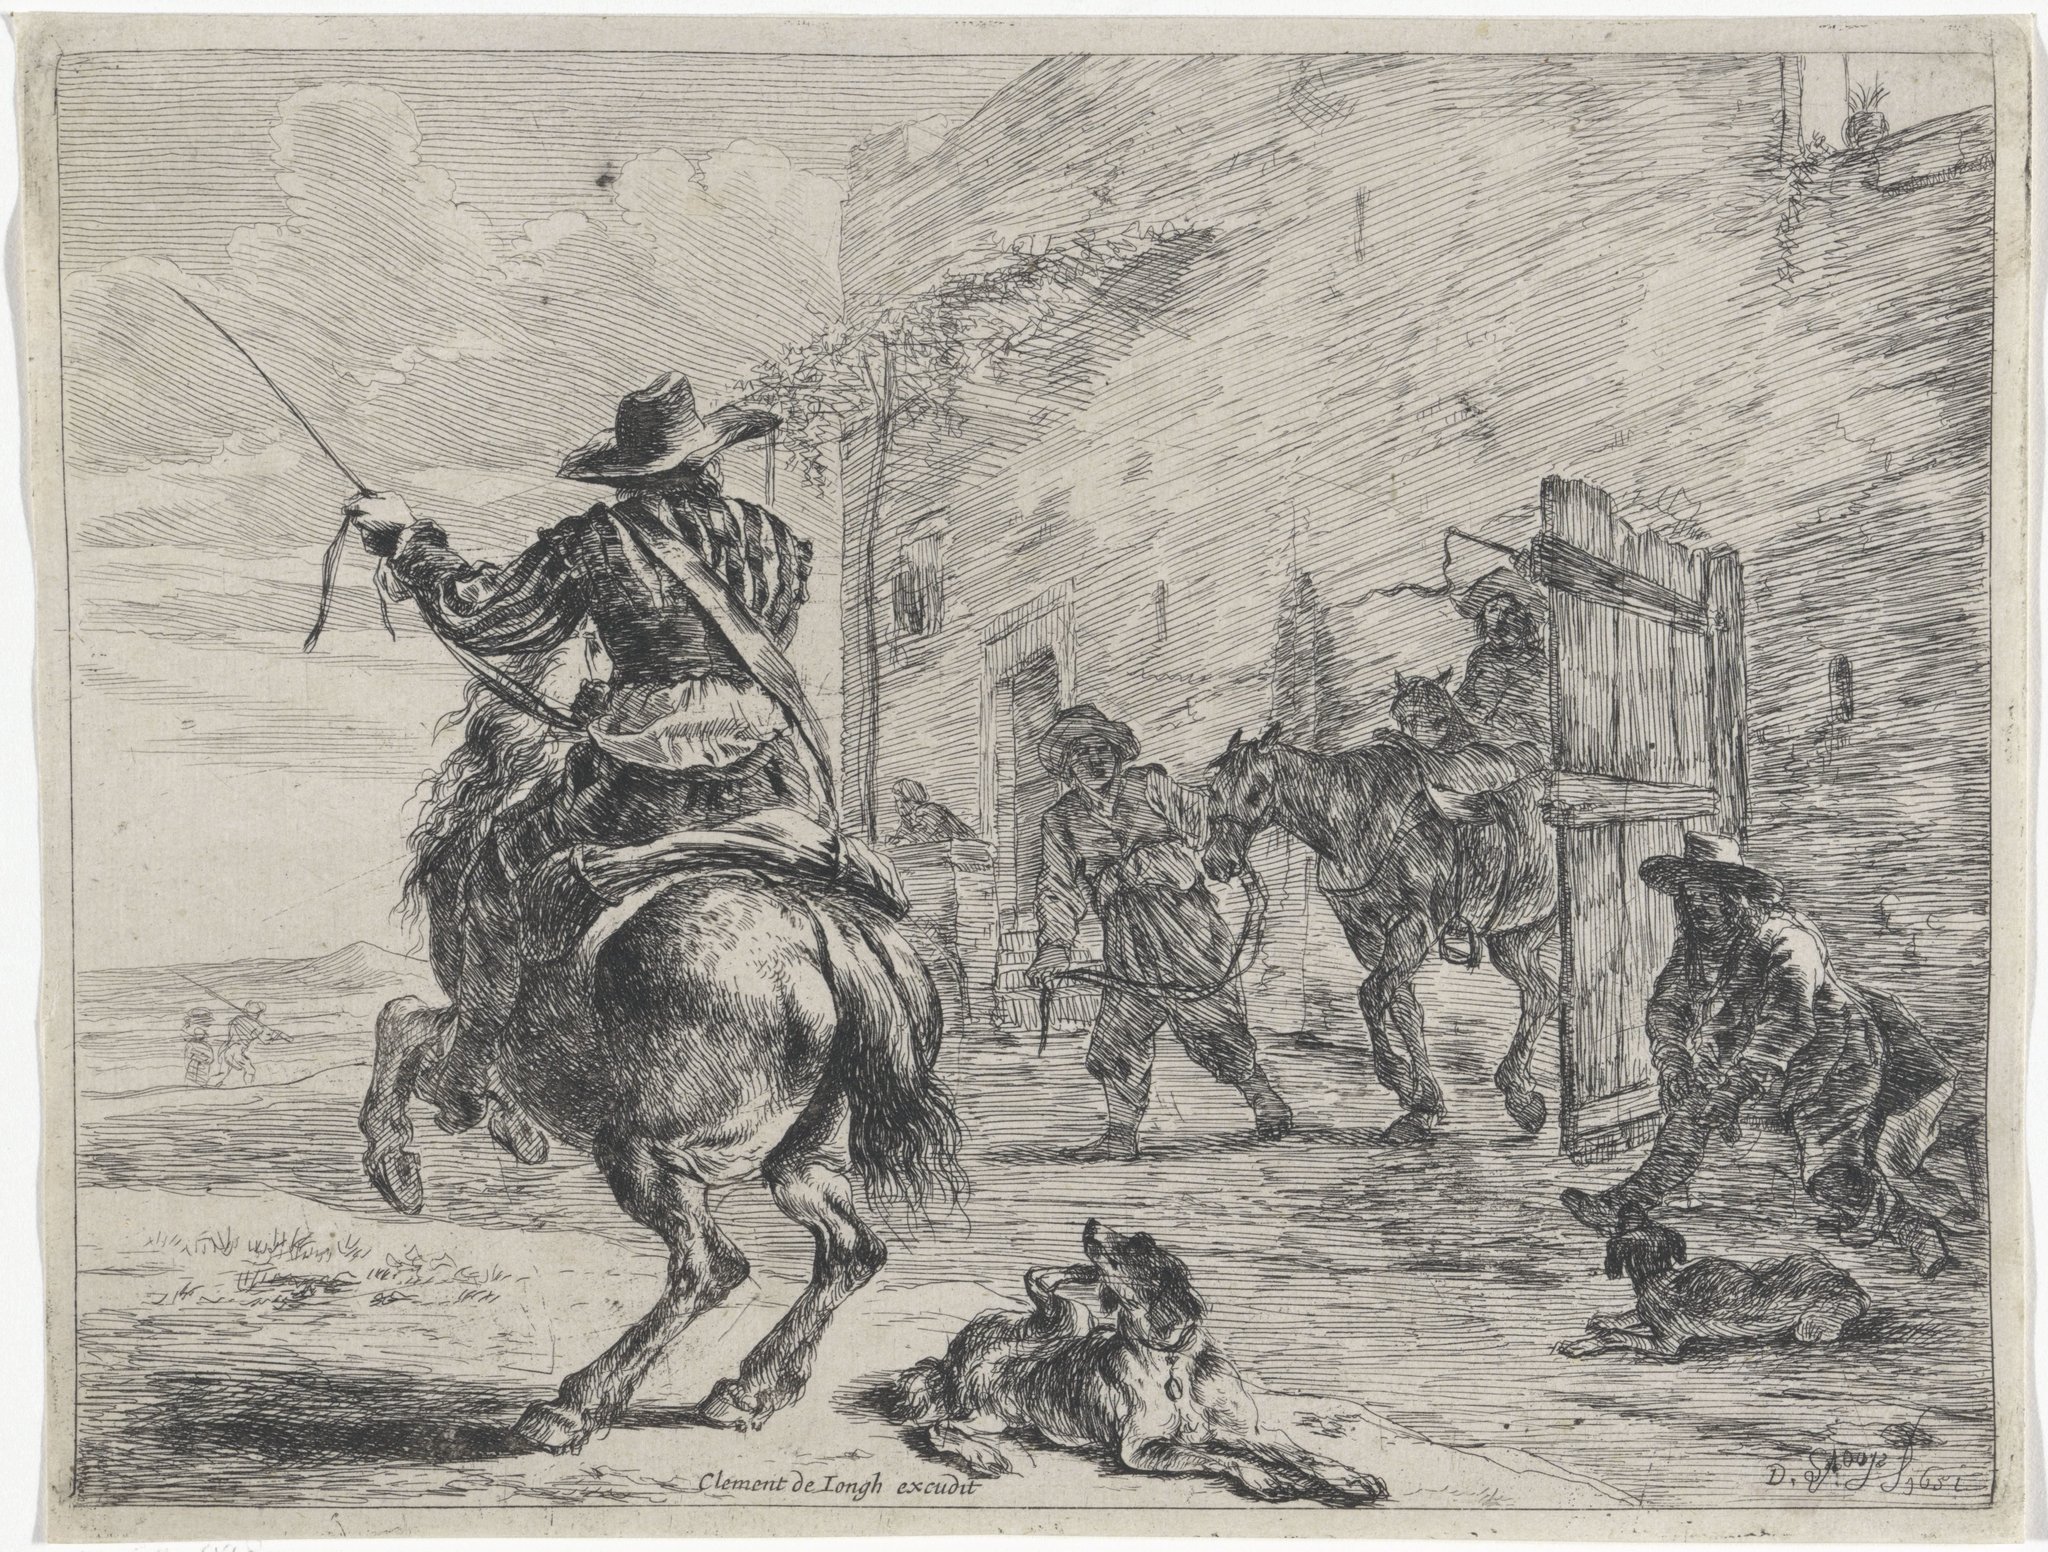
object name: print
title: Paarden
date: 1651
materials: paper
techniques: etching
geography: amsterdam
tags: horse, stall, stable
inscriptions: collector's mark: Lugt 2228, collector's mark: Lugt 240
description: Een ruiter met een zweep in de hand zit op een steigerend paard. Rechts leidt een man een paard aan de teugels uit een stal. Op de voorgrond een liggende hond.